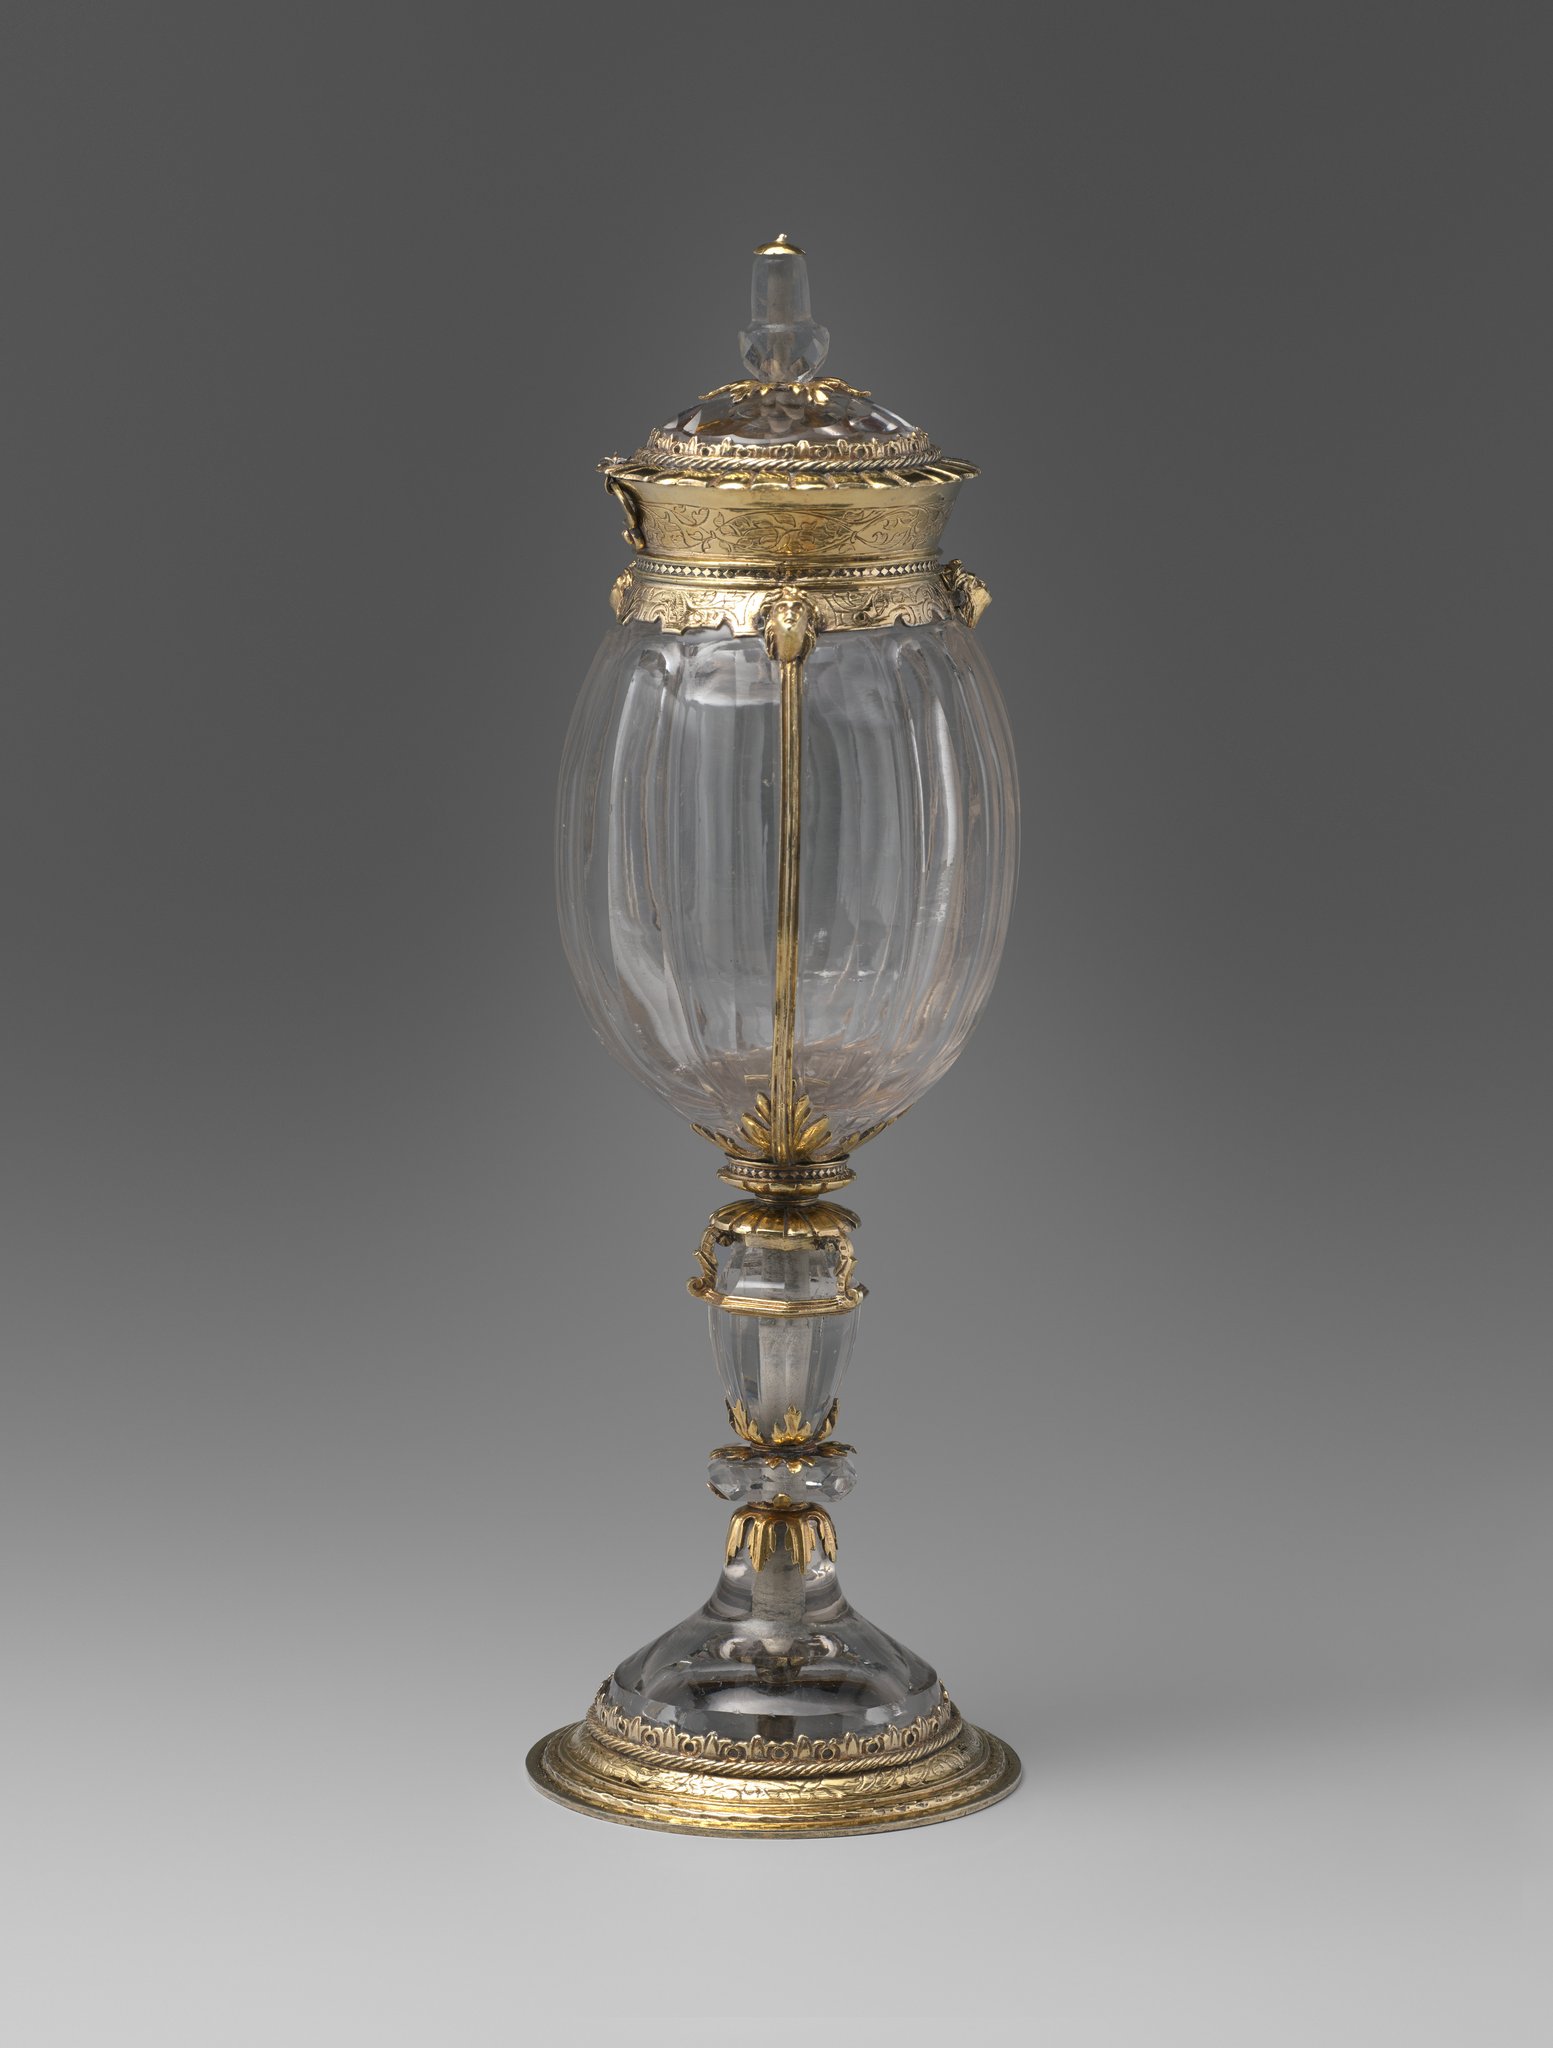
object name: cup with cover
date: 1560-1570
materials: gilt silver, quartz